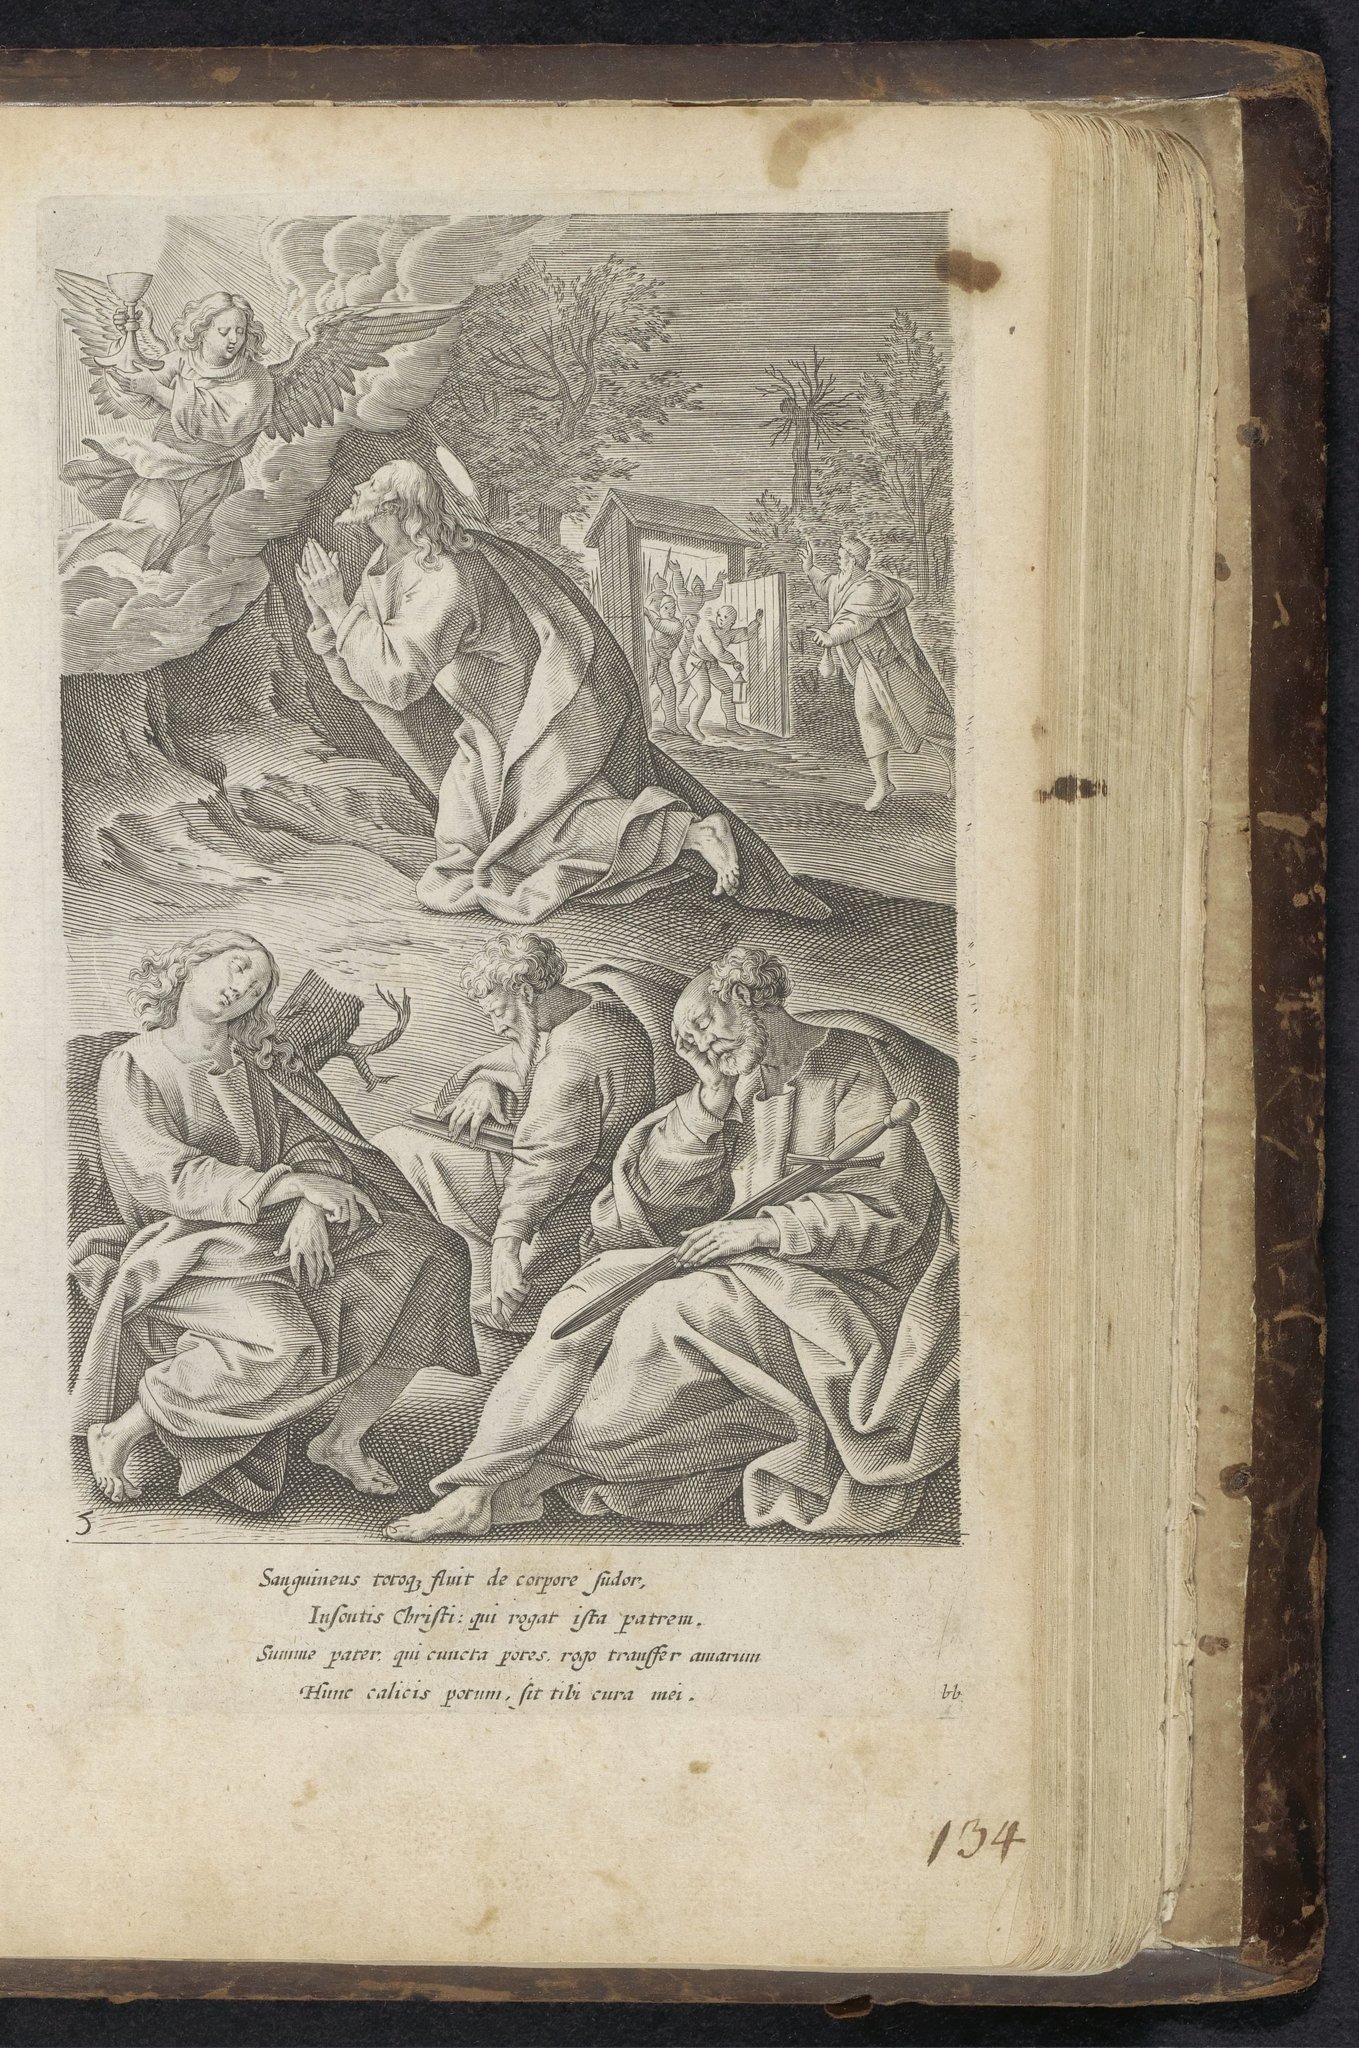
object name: album leaf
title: Christus in de hof van Getsemane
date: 1585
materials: paper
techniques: engraving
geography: alkmaar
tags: agony of christ; three (or eleven) apostles sleeping, christ's prayer in the garden of gethsemane during the night, agony of christ: to comfort him one or more angels appear to christ with chalice and/or cross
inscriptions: number: ‘134’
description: Christus bidt in de hof van Getsemane. Uit de hemel verschijnt een engel met een kelk. Op de voorgrond slapen Petrus, Johannes en Jacobus. Op de achtergrond leidt Judas een groep soldaten door de poort naar binnen. Onder de voorstelling een vierregelig vers in het Latijn. Rechtsonder de letters: bb. Deze prent maakt deel uit van een album.